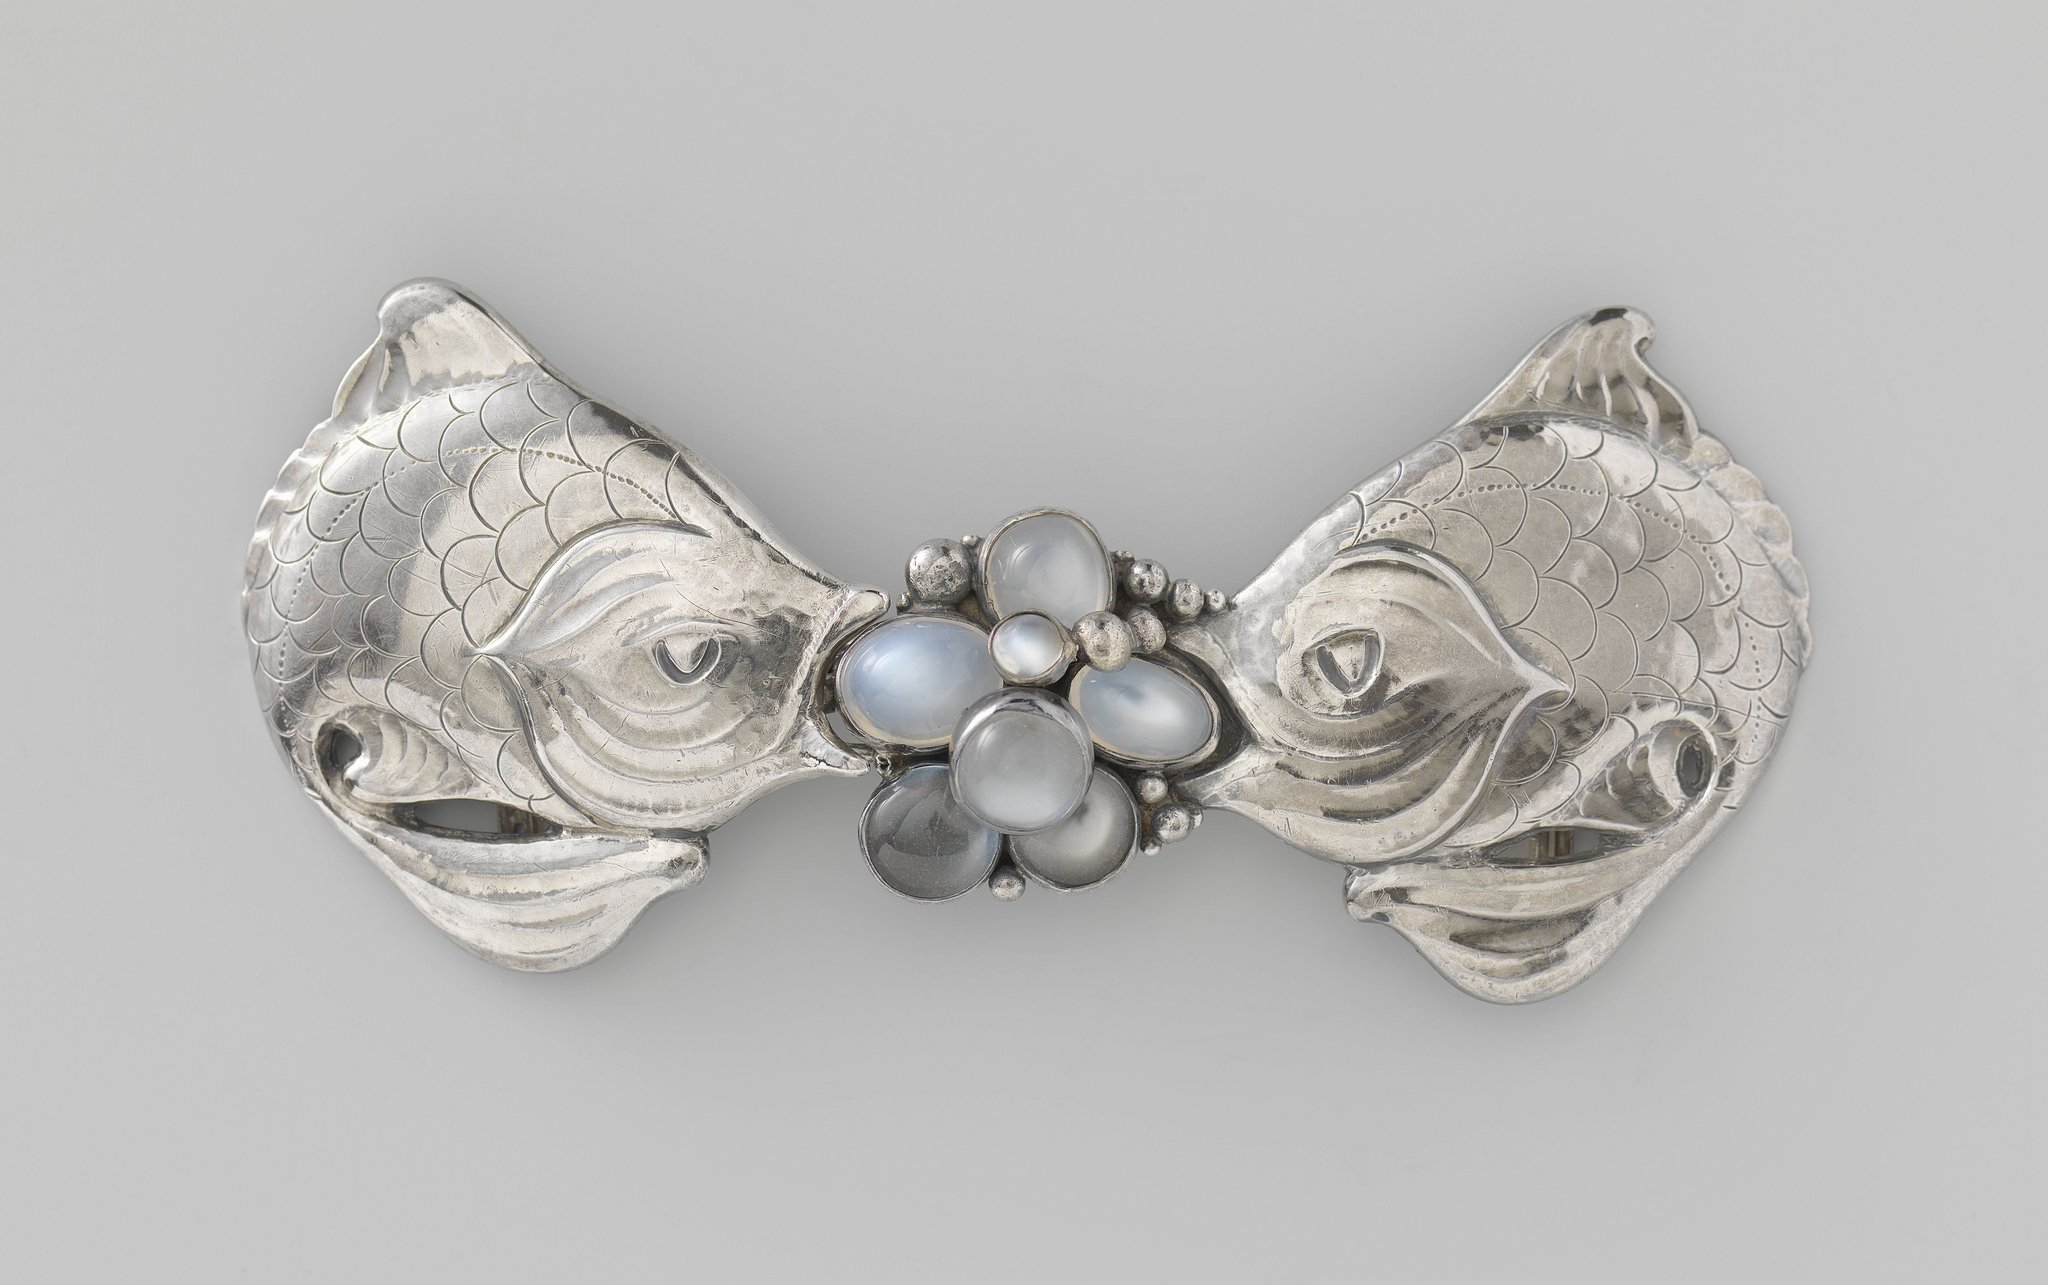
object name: jewellery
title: Gesp in de vorm van twee vissen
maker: carl christian fjerdingstad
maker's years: 1891-1968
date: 1911-1914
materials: mineral, silver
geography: skagen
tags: fishes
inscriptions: monogram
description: Clasp. Silver and moonstones. Skagen (Denmark), 1911 - 1914, by Carl Christian Fjerdingstad.